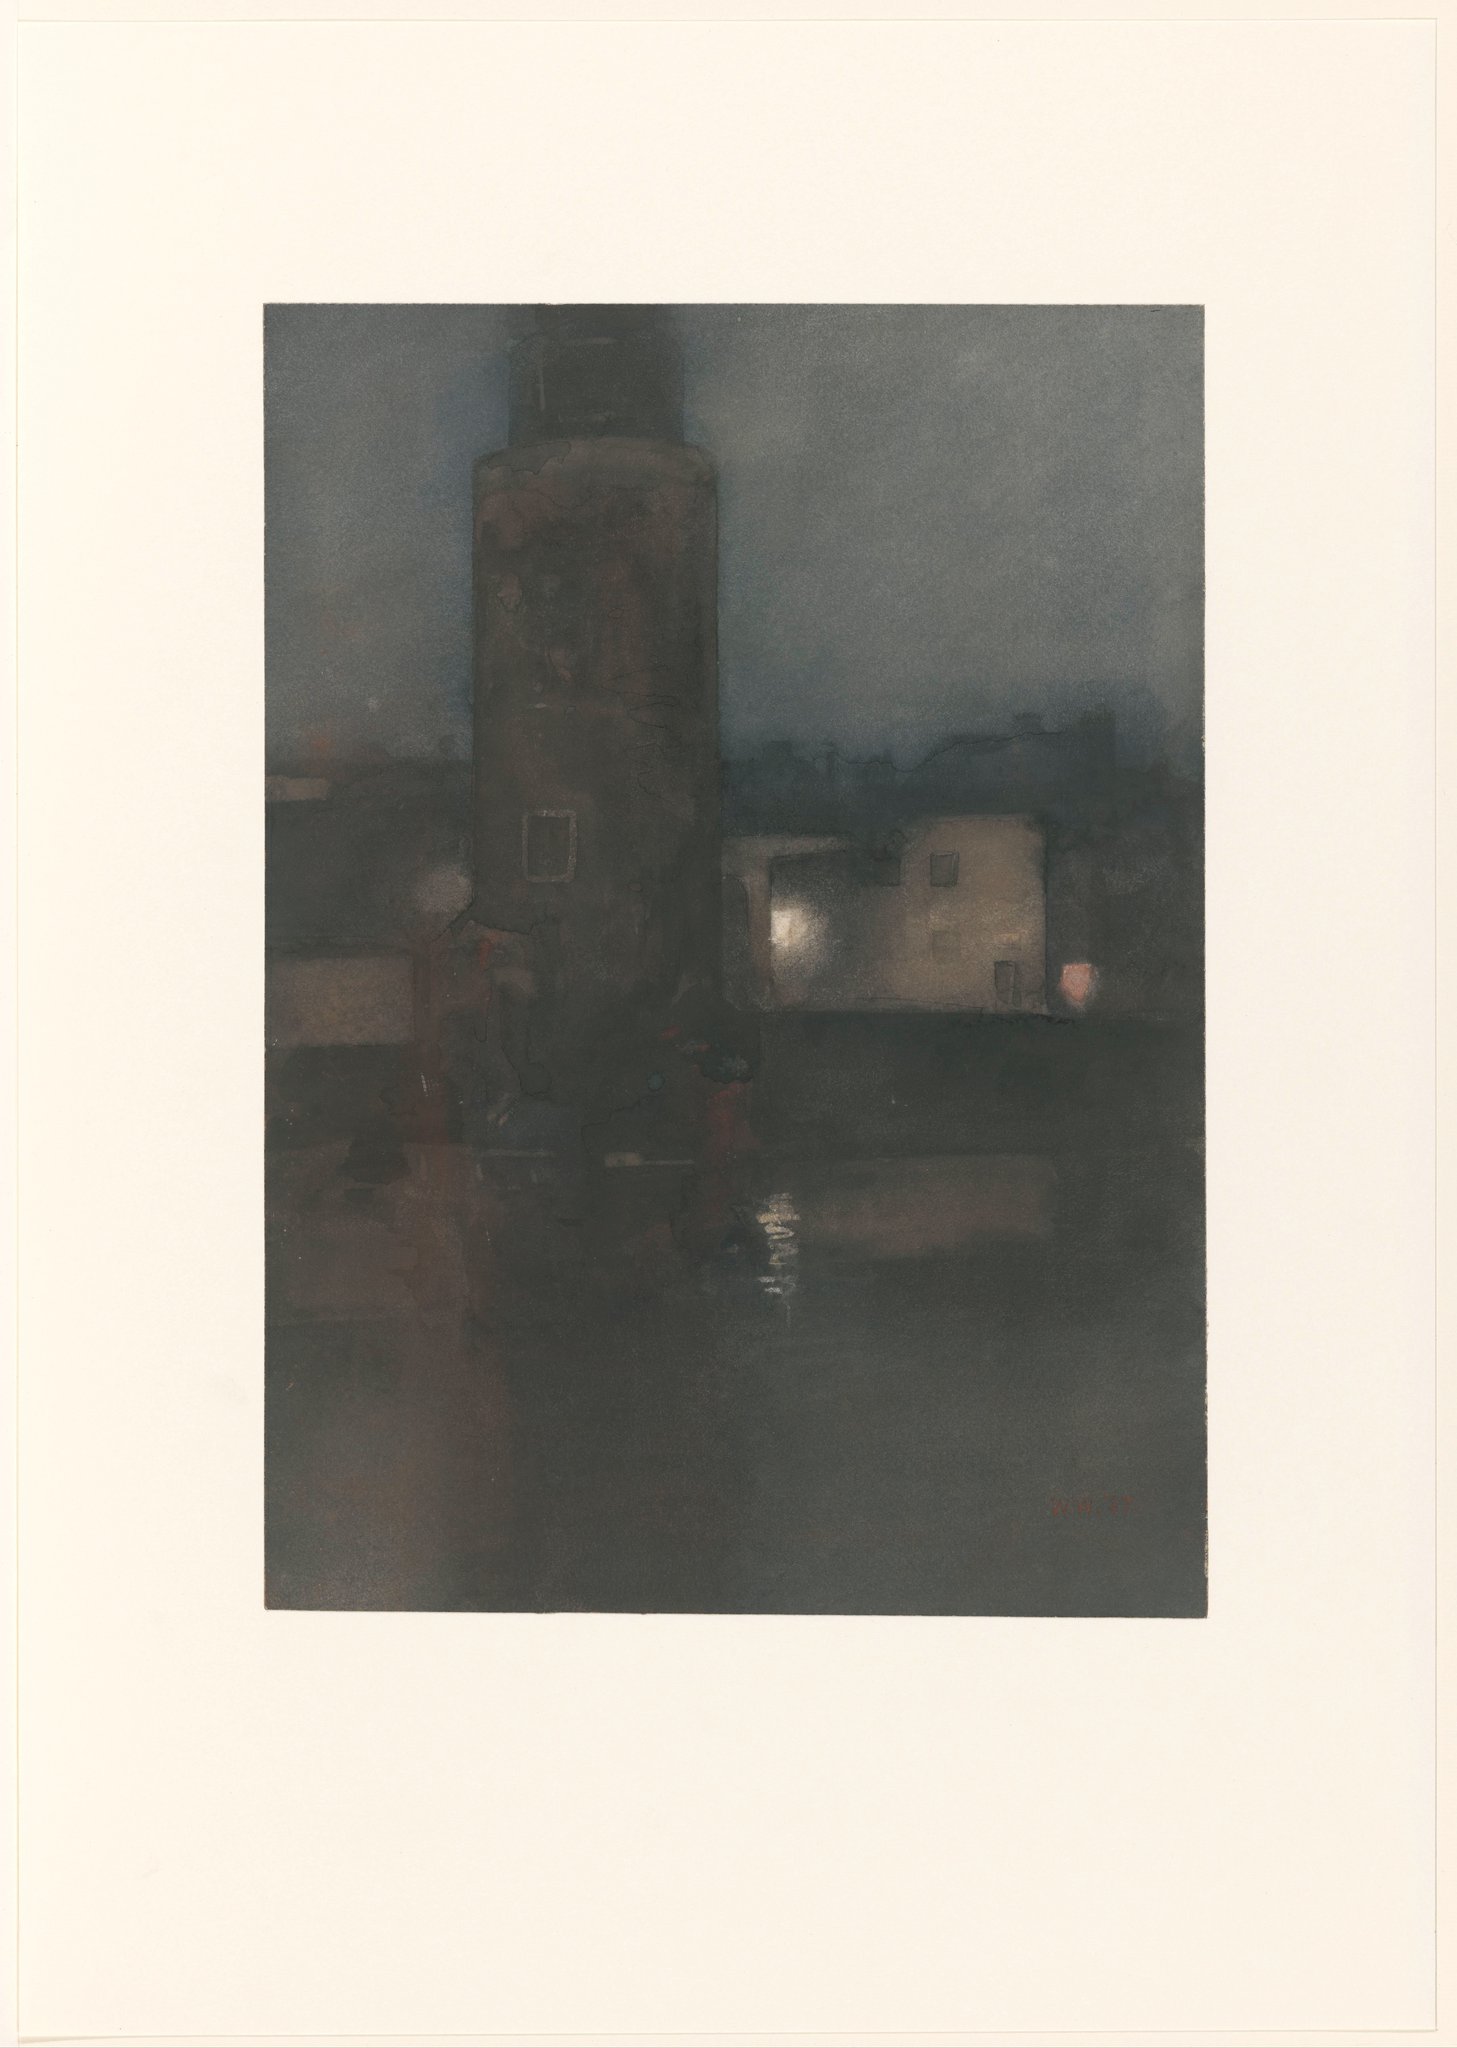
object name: watercolor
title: De Montelbaanstoren te Amsterdam bij nacht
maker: willem witsen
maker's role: draughtsman, painter, print maker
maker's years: 1860-1923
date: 1887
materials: paper, watercolor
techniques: brush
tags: night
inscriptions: date: ‘87’